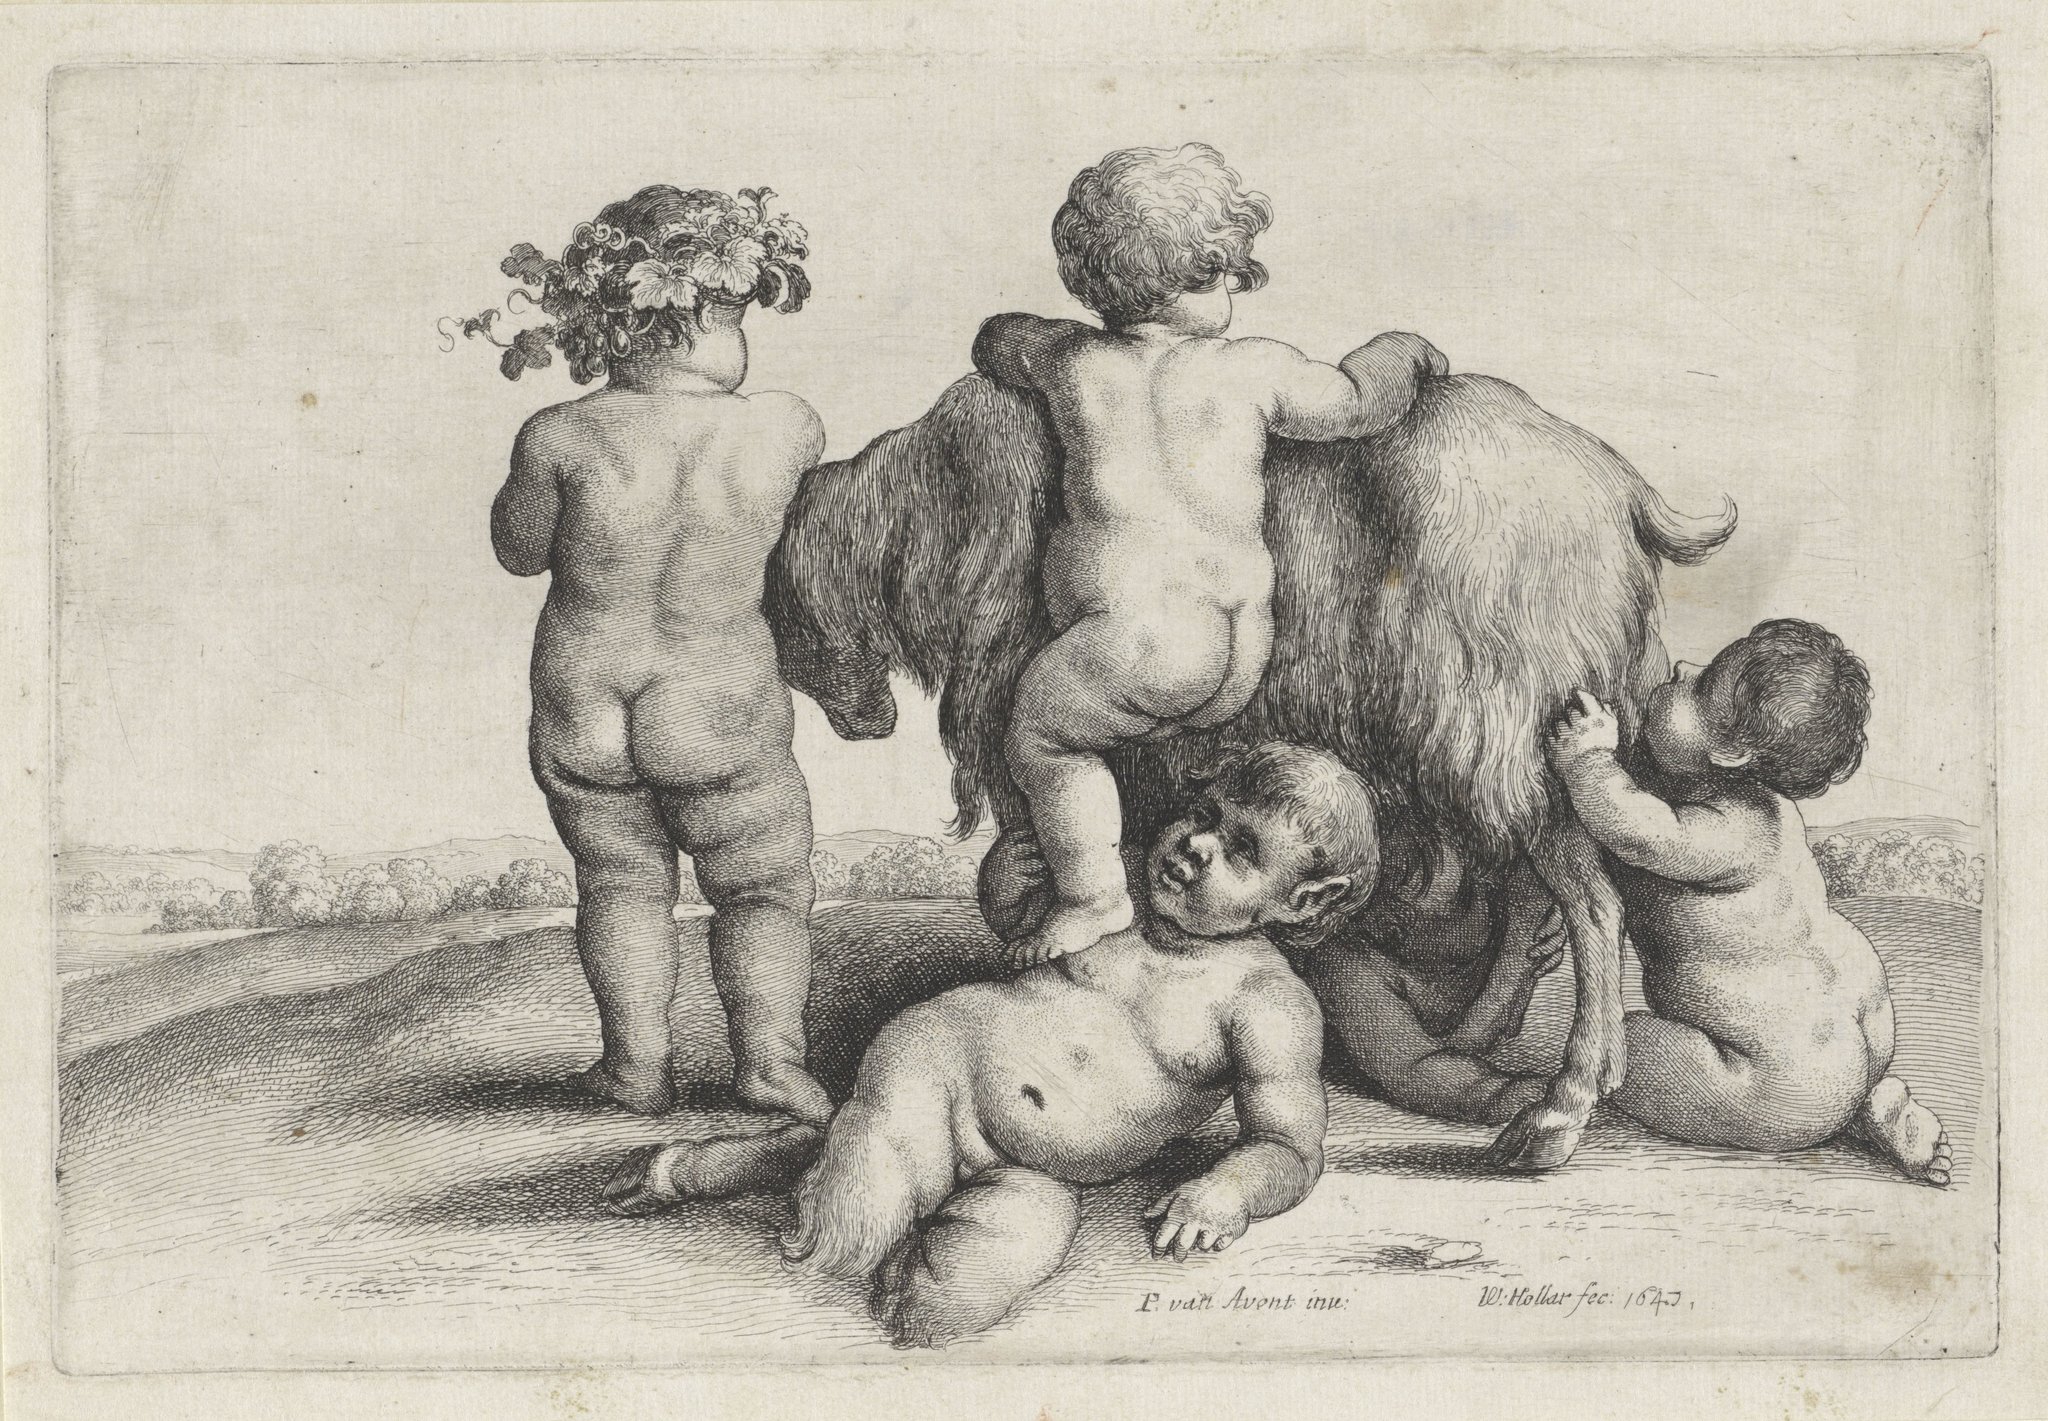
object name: print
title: Vier jongetjes, een sater en een geit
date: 1647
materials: paper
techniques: etching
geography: antwerp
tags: boy (child between toddler and youth), satyr(s) (in general), goat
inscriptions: collector's mark: Lugt 240